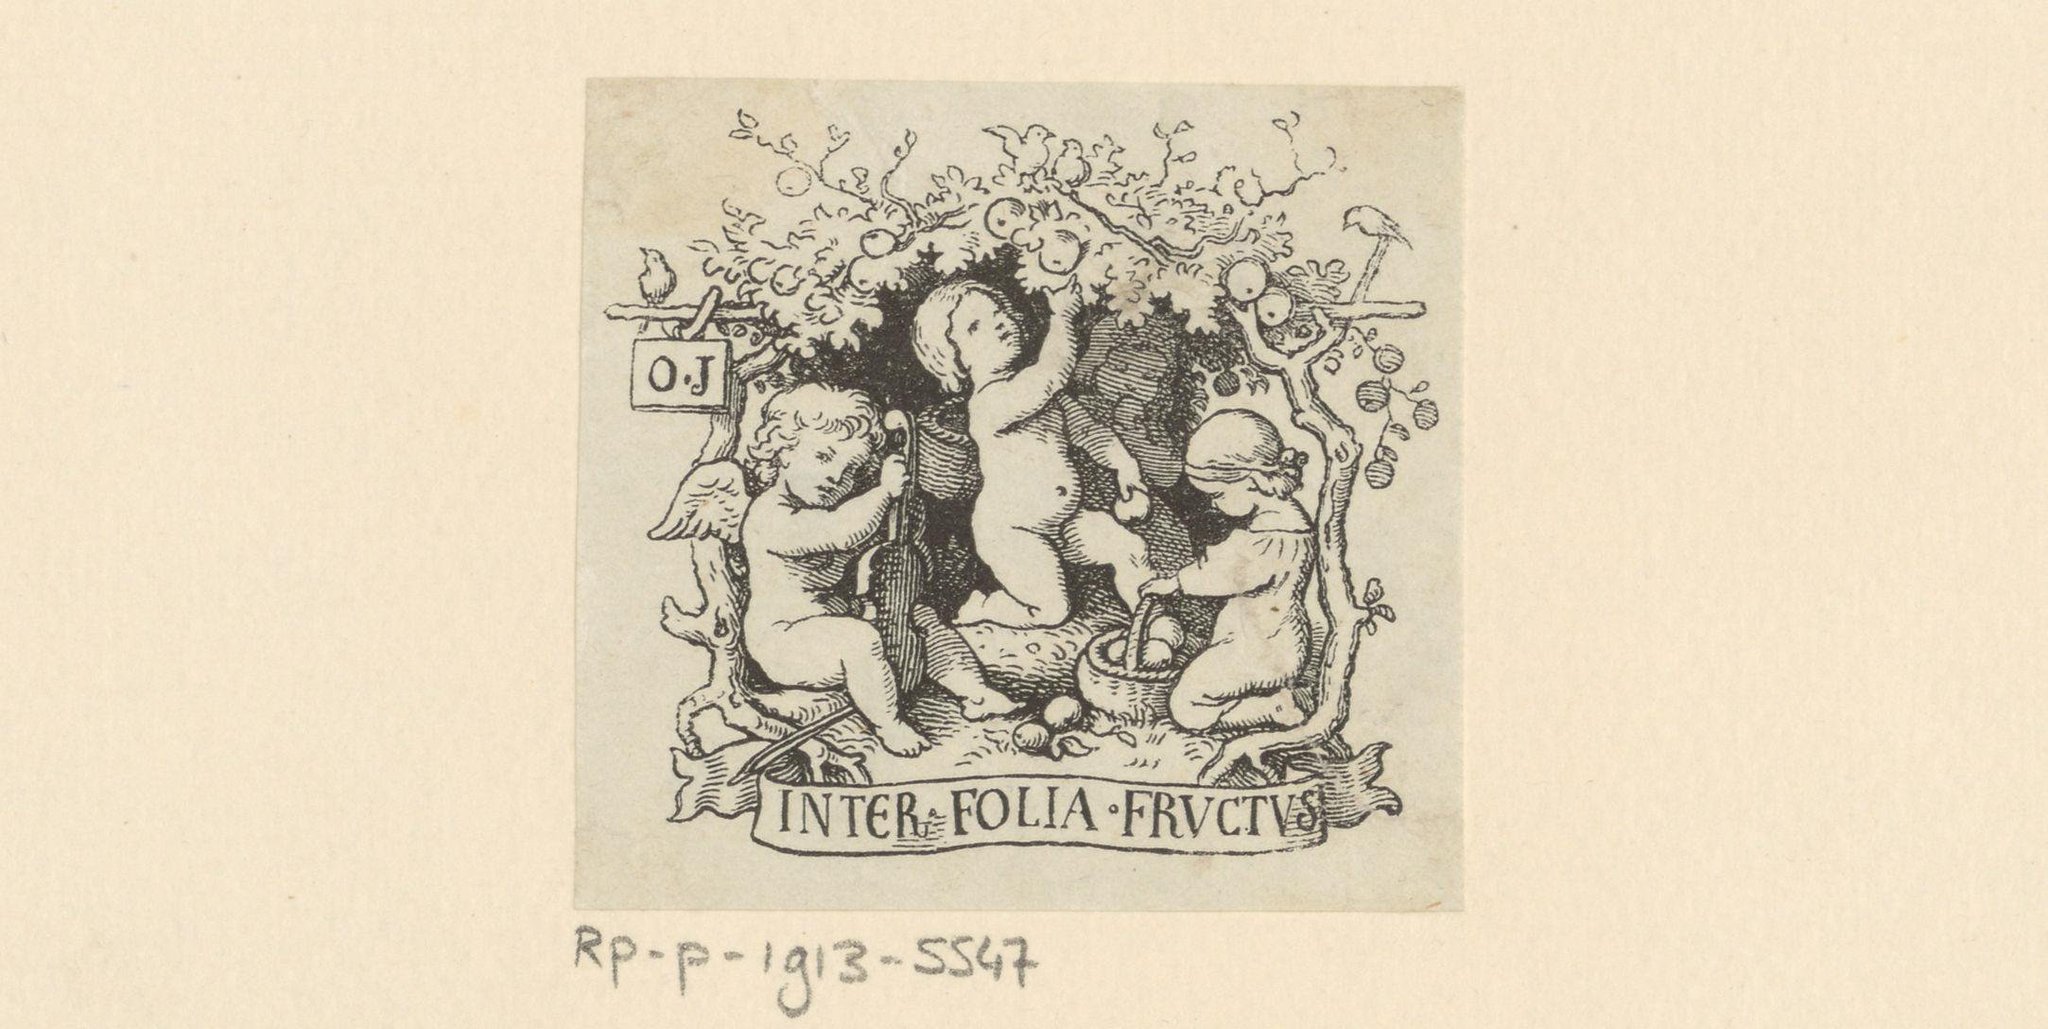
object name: photomechanical print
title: Inter folia fructus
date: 1850-1869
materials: paper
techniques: printing block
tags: trees: apple-tree, cupids: 'amores', 'amoretti', 'putti'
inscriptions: collector's mark: Lugt 2760, collector's mark: Lugt 2233